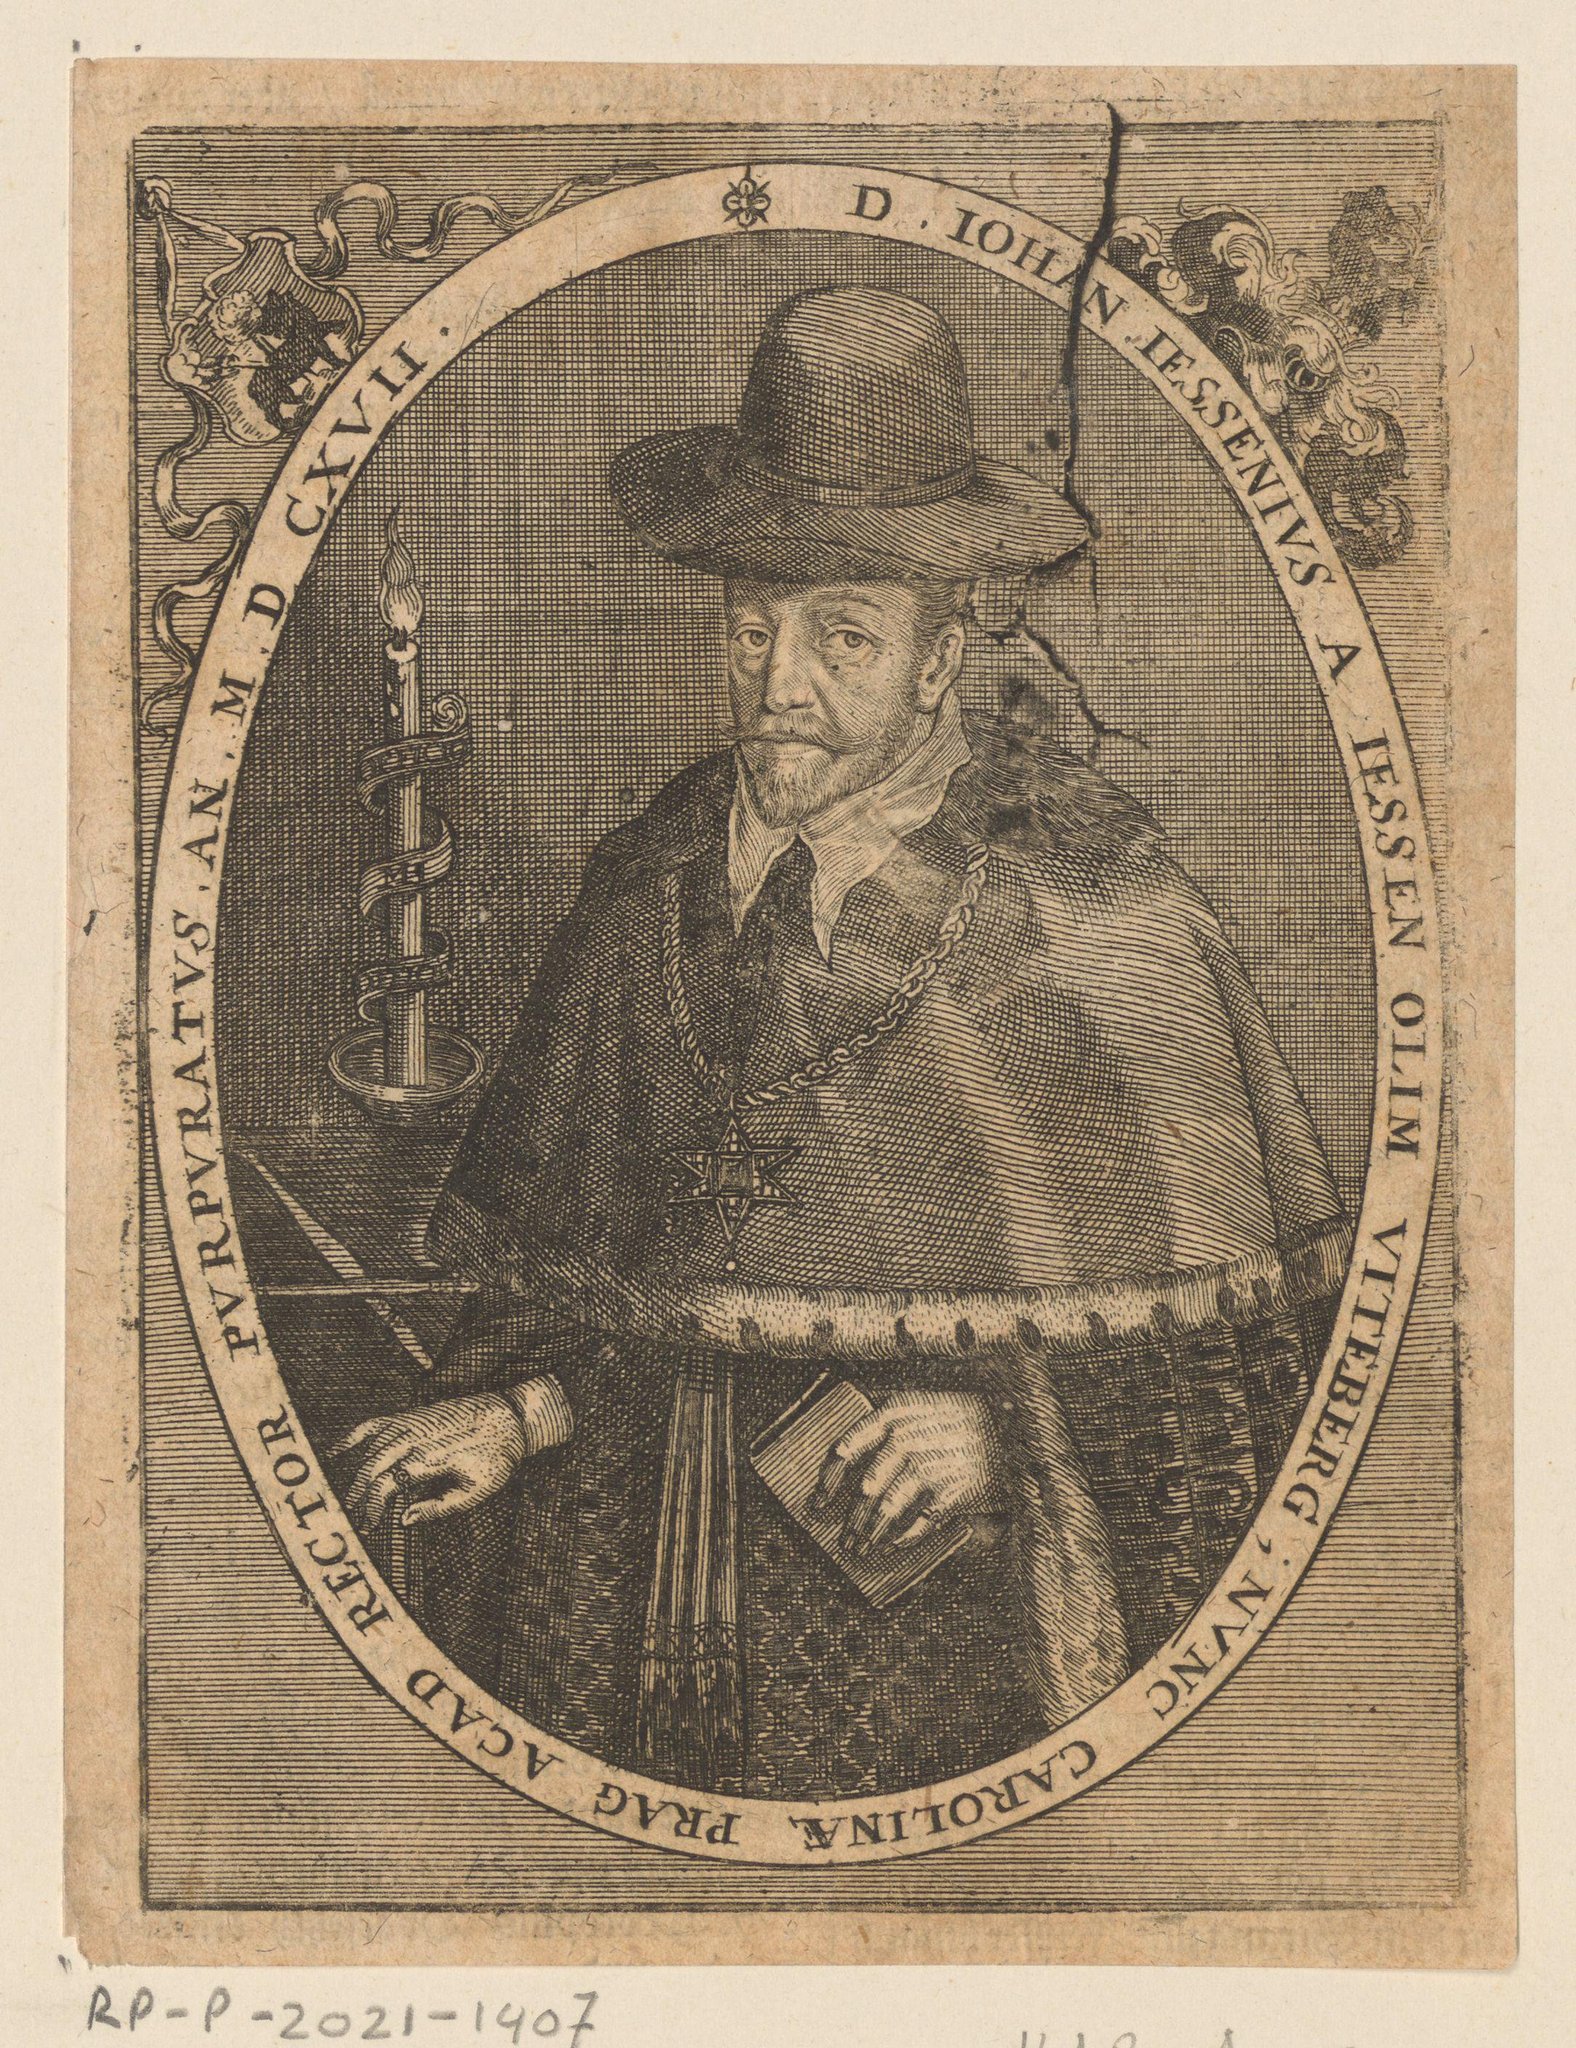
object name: print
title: Portret van Johann von Jessen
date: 1662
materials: paper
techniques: engraving, letterpress printing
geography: frankfurt am main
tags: prague, historical persons, physician, doctor, book, candle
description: Prent uit: Abelin, Johann Philipp. Theatrum Europaeum. Frankfurt am Main: erven Matthäus Merian I, 1662, dl. 1.